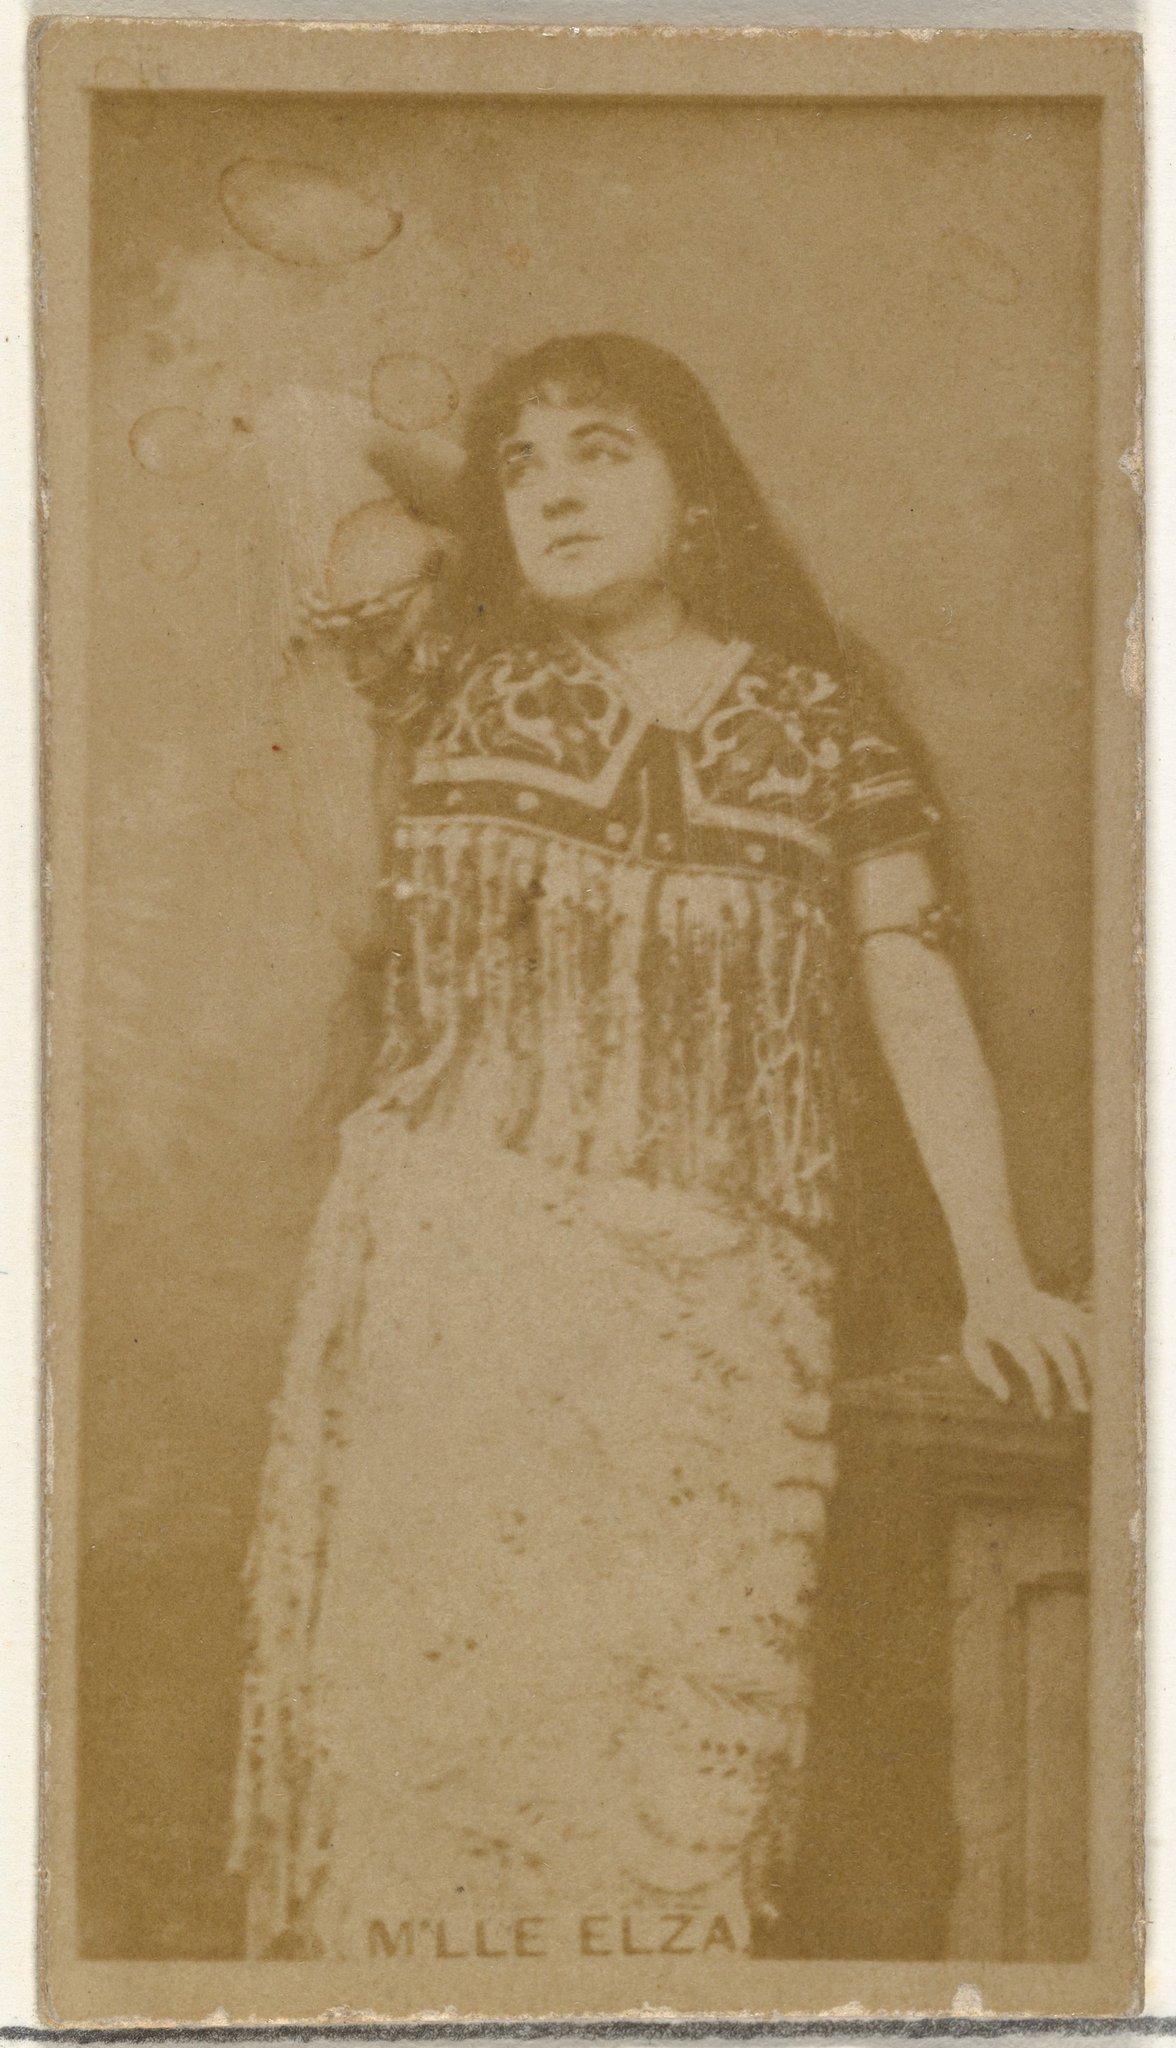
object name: photograph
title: M'lle Elza, from the Actors and Actresses series (N145-8) issued by Duke Sons & Co. to promote Duke Cigarettes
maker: w. duke, sons & co.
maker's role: publisher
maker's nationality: american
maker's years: 1870-1920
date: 1891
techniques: albumen silver print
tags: portraits,women,actresses